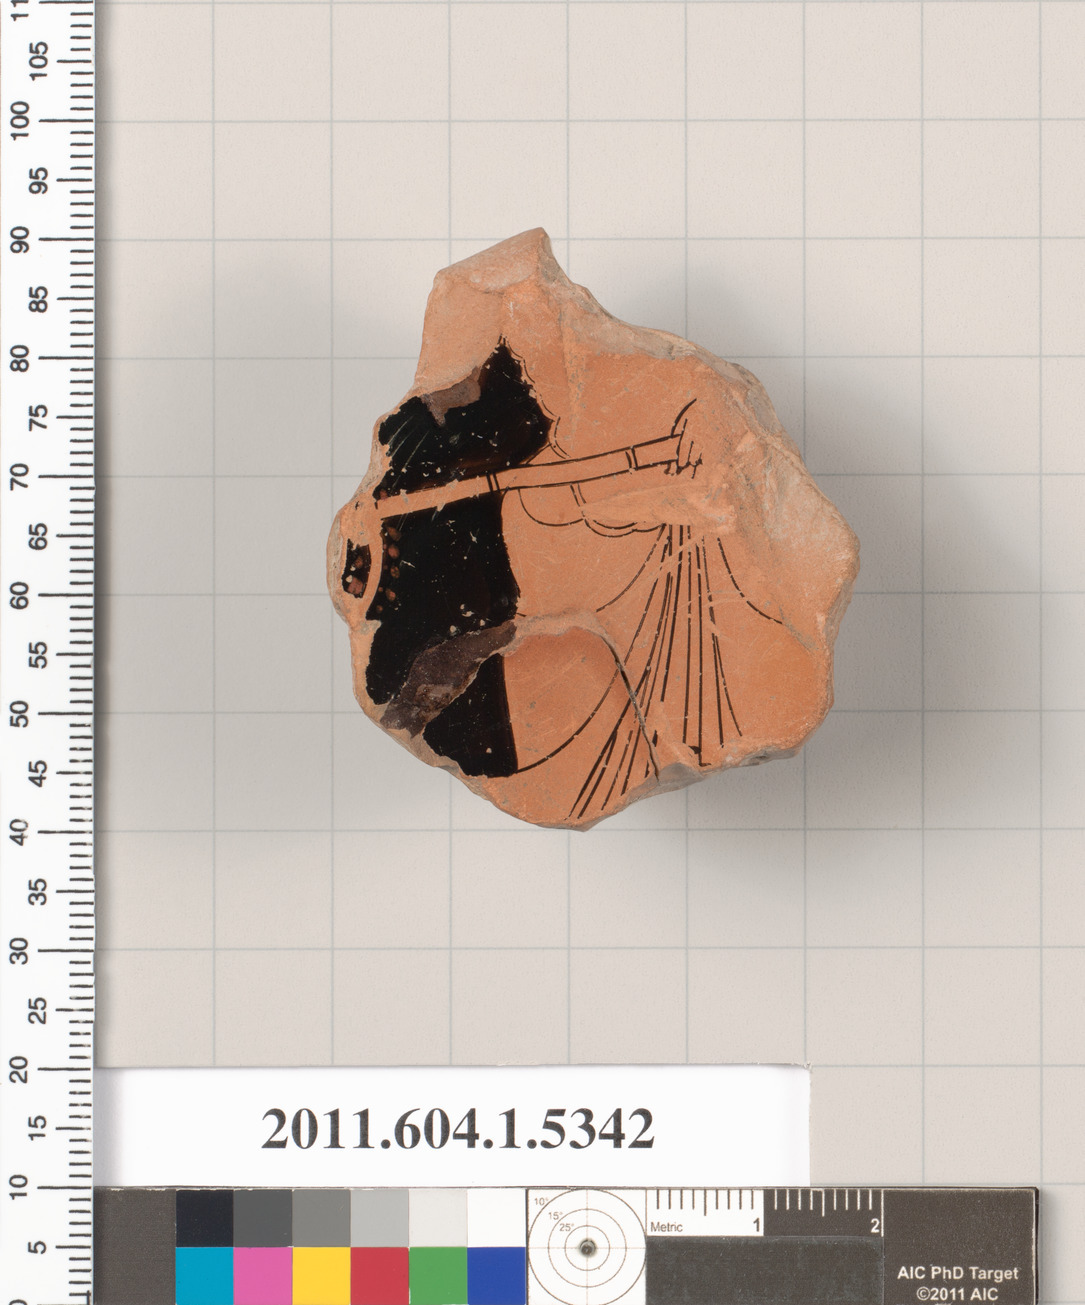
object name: kylix fragment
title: Terracotta fragment of a kylix (drinking cup)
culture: greek, attic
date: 500-480 BCE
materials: terracotta